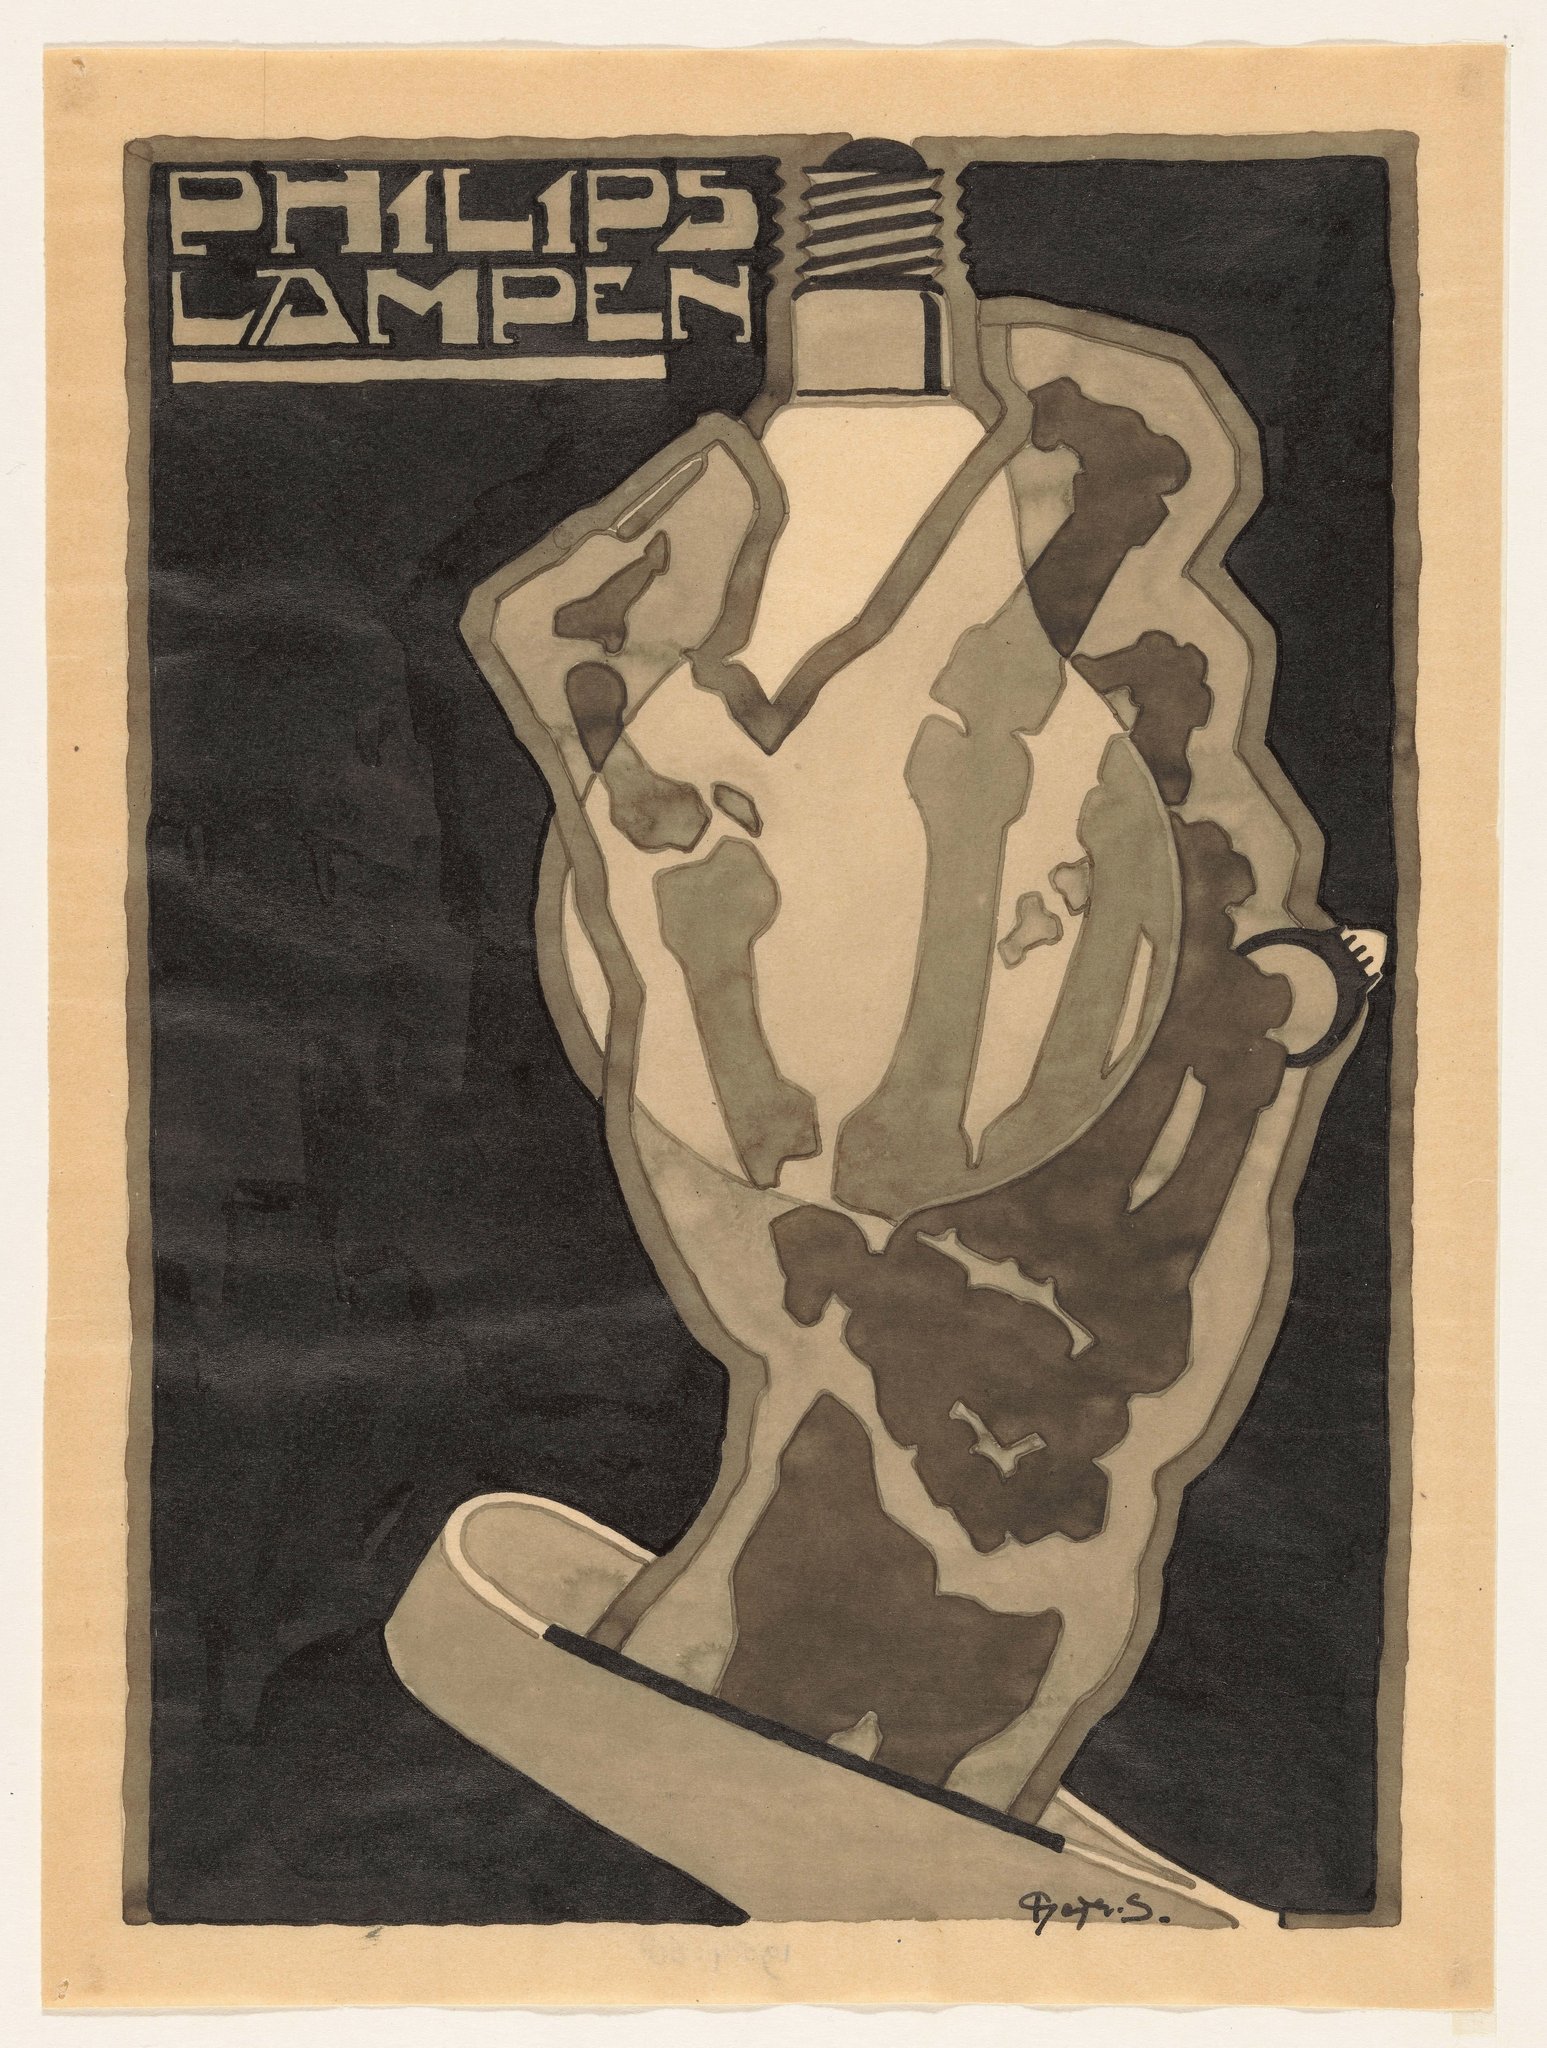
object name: drawing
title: Assorted Philips lightbulbs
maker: reijer stolk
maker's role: draughtsman, print maker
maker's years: 1896-1945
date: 1916-1945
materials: ink, paper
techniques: brush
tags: (other) historical names, advertisement, notice, electric lamp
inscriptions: collector's mark: Lugt 2228, collector's mark: Lugt 2760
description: Wilhelm Röntgen printed the world’s very first X-radiographs in late December 1895. These included what would become an iconic photograph of his wife’s hand with a ring. It is obvious that the artist and advertising designer Stolk was inspired by the photograph when he designed this poster for lightbulbs.